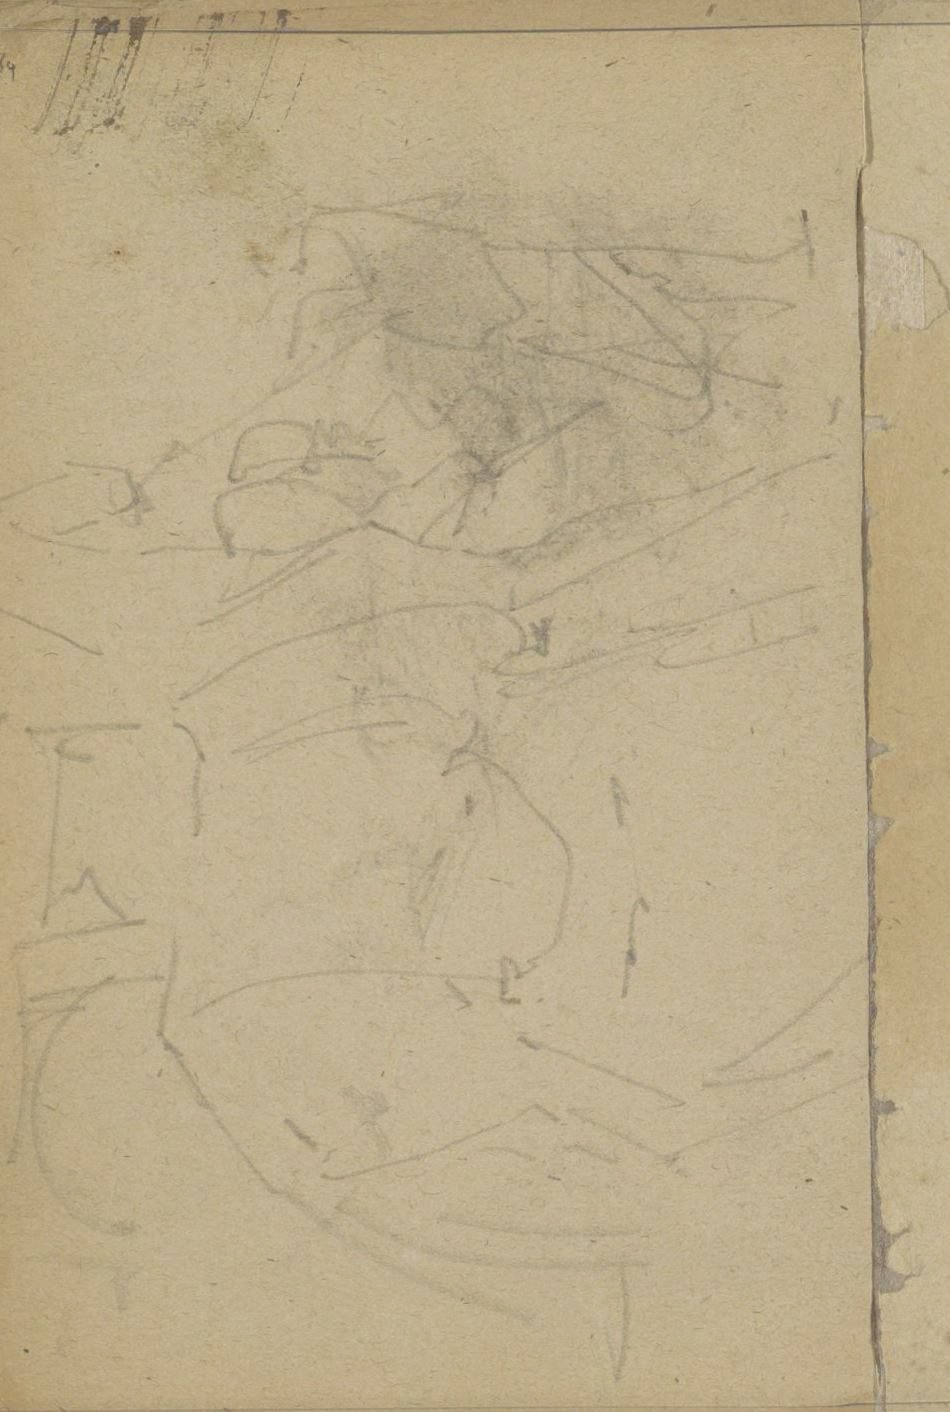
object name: sketchbook leaf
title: Figuur bij een paard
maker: george hendrik breitner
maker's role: draughtsman, painter, print maker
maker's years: 1857-1923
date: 1881-1883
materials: paper, pencil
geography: south holland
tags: adult man, horse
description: Eén of twee figuren bij een gezadeld paard. Een figuur houdt het leidsel vast. Pagina 84 uit een schetsboek met 70 bladen.